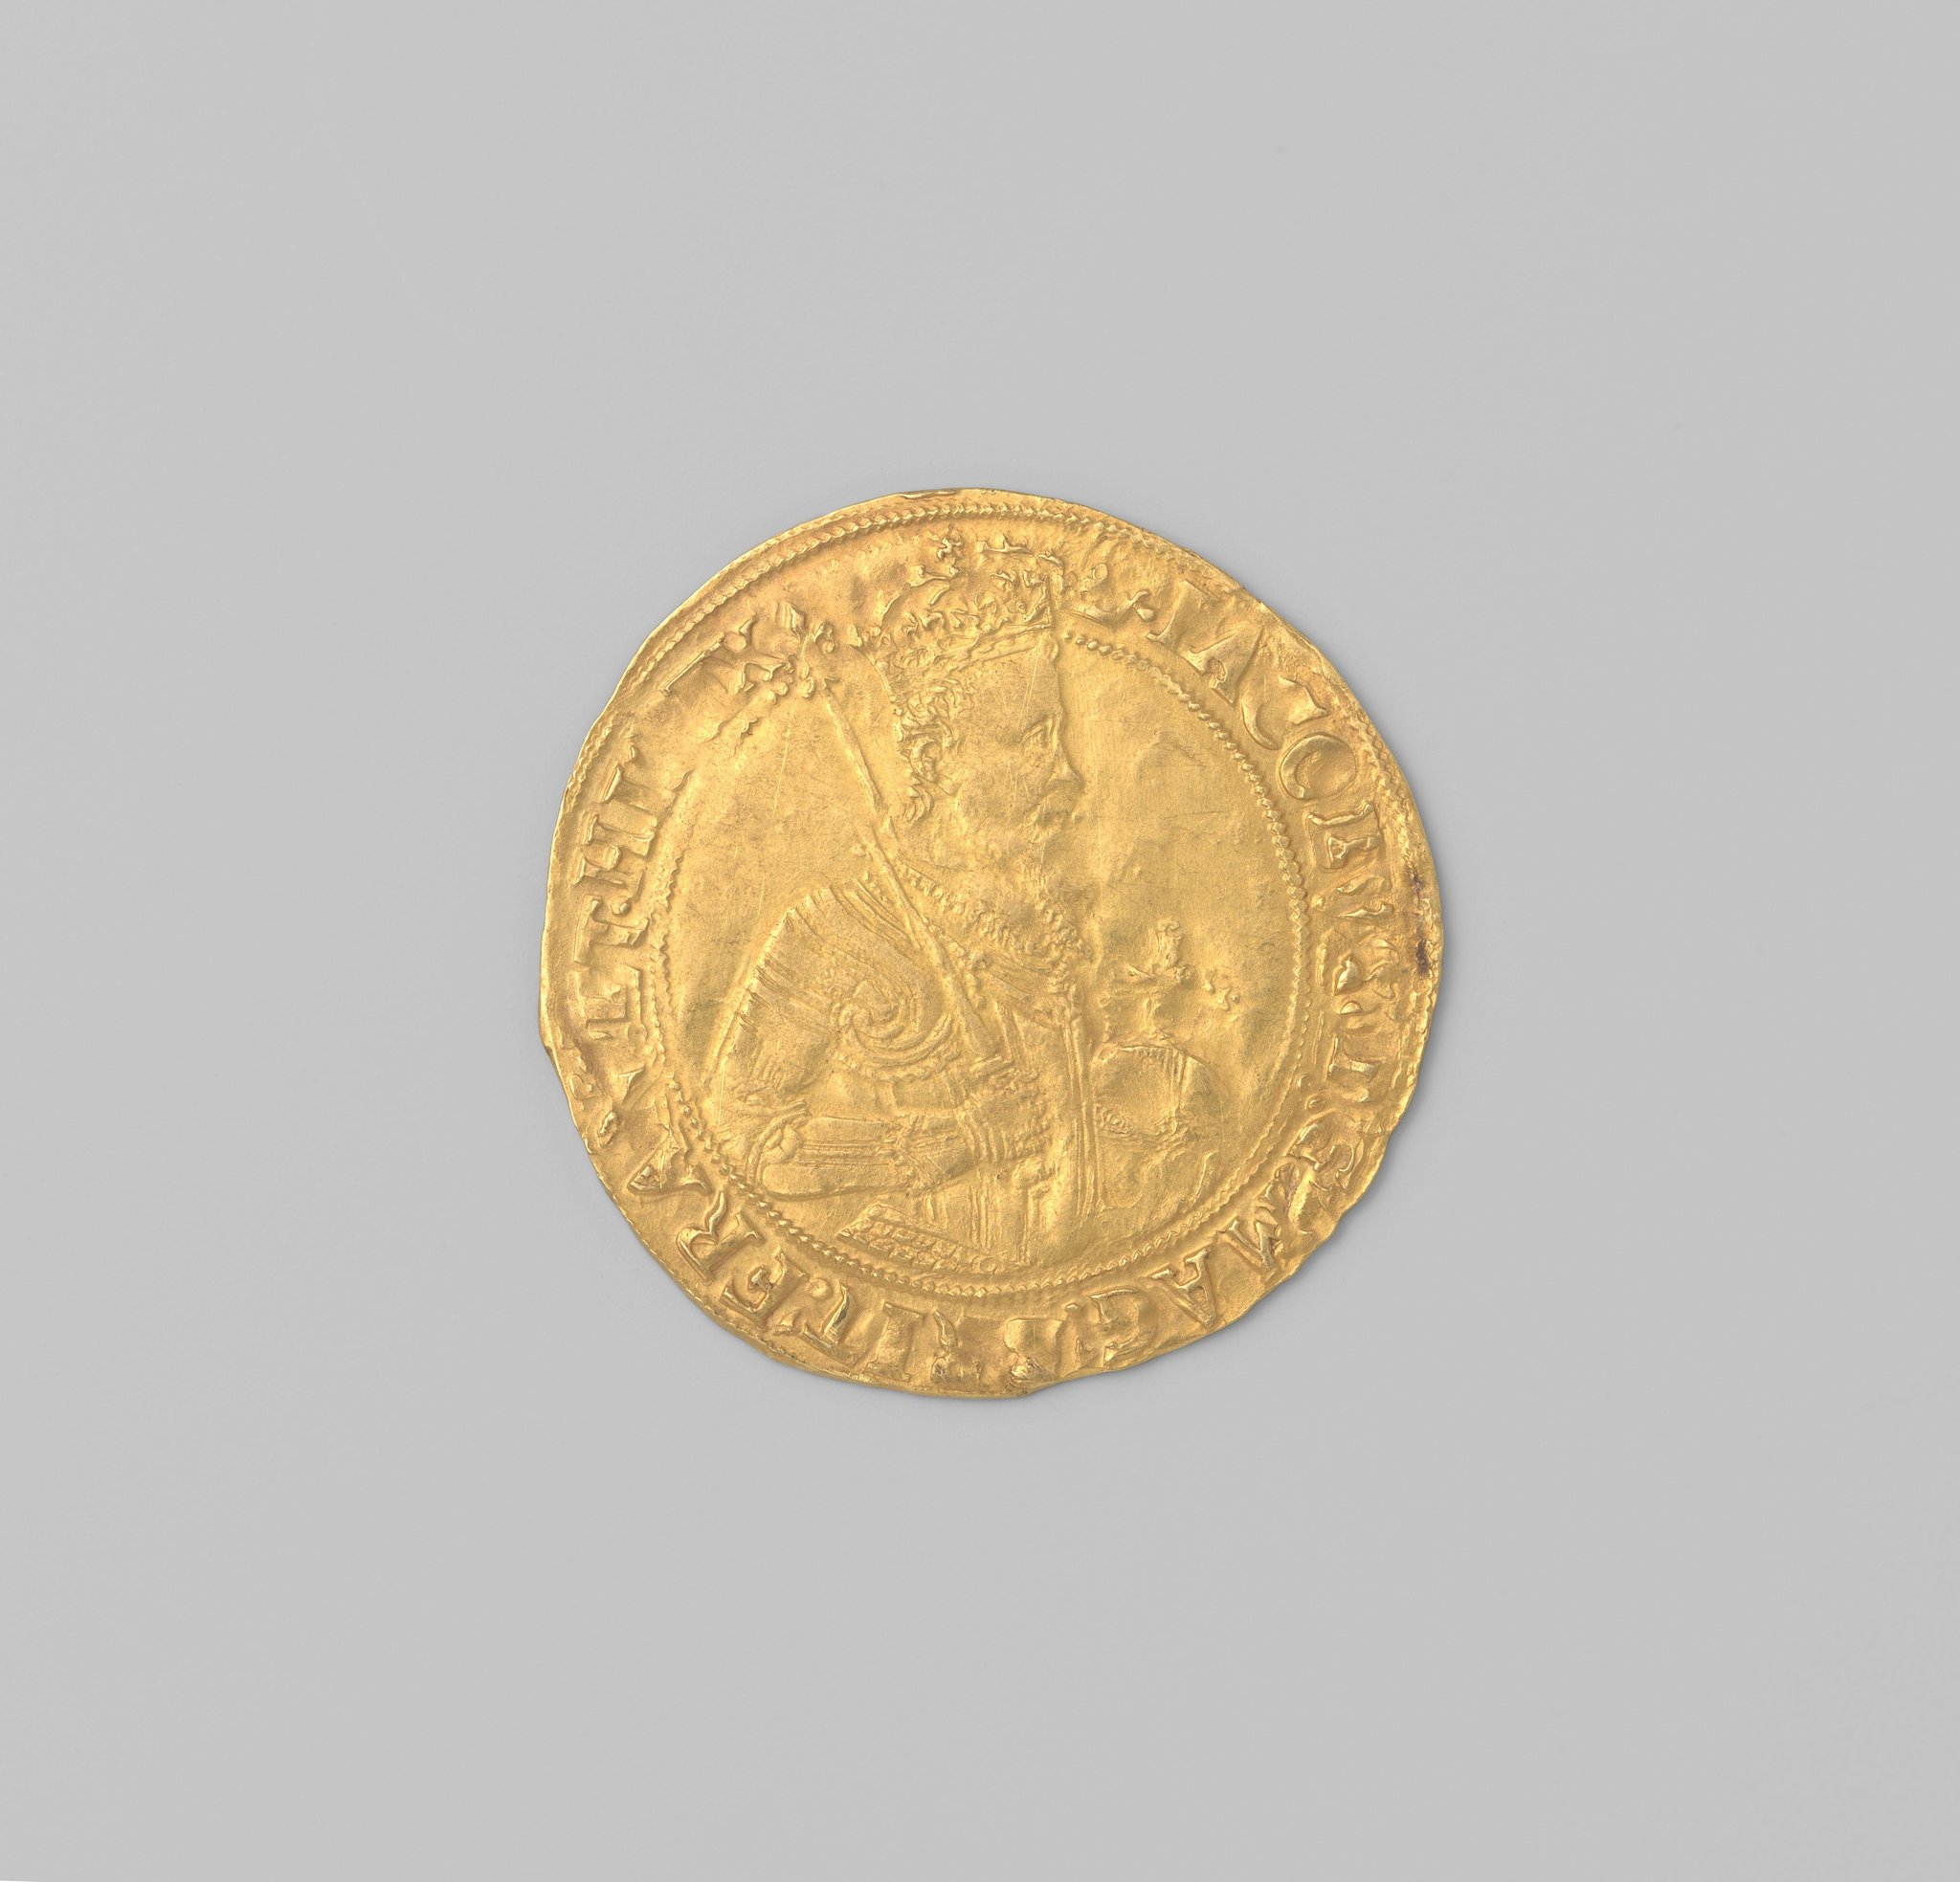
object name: coin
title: Gouden unite James I, met houder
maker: Anonymous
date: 1600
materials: gold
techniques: striking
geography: europe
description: Gouden handelsmunt afkomstig uit Nederlandse muntvondst.